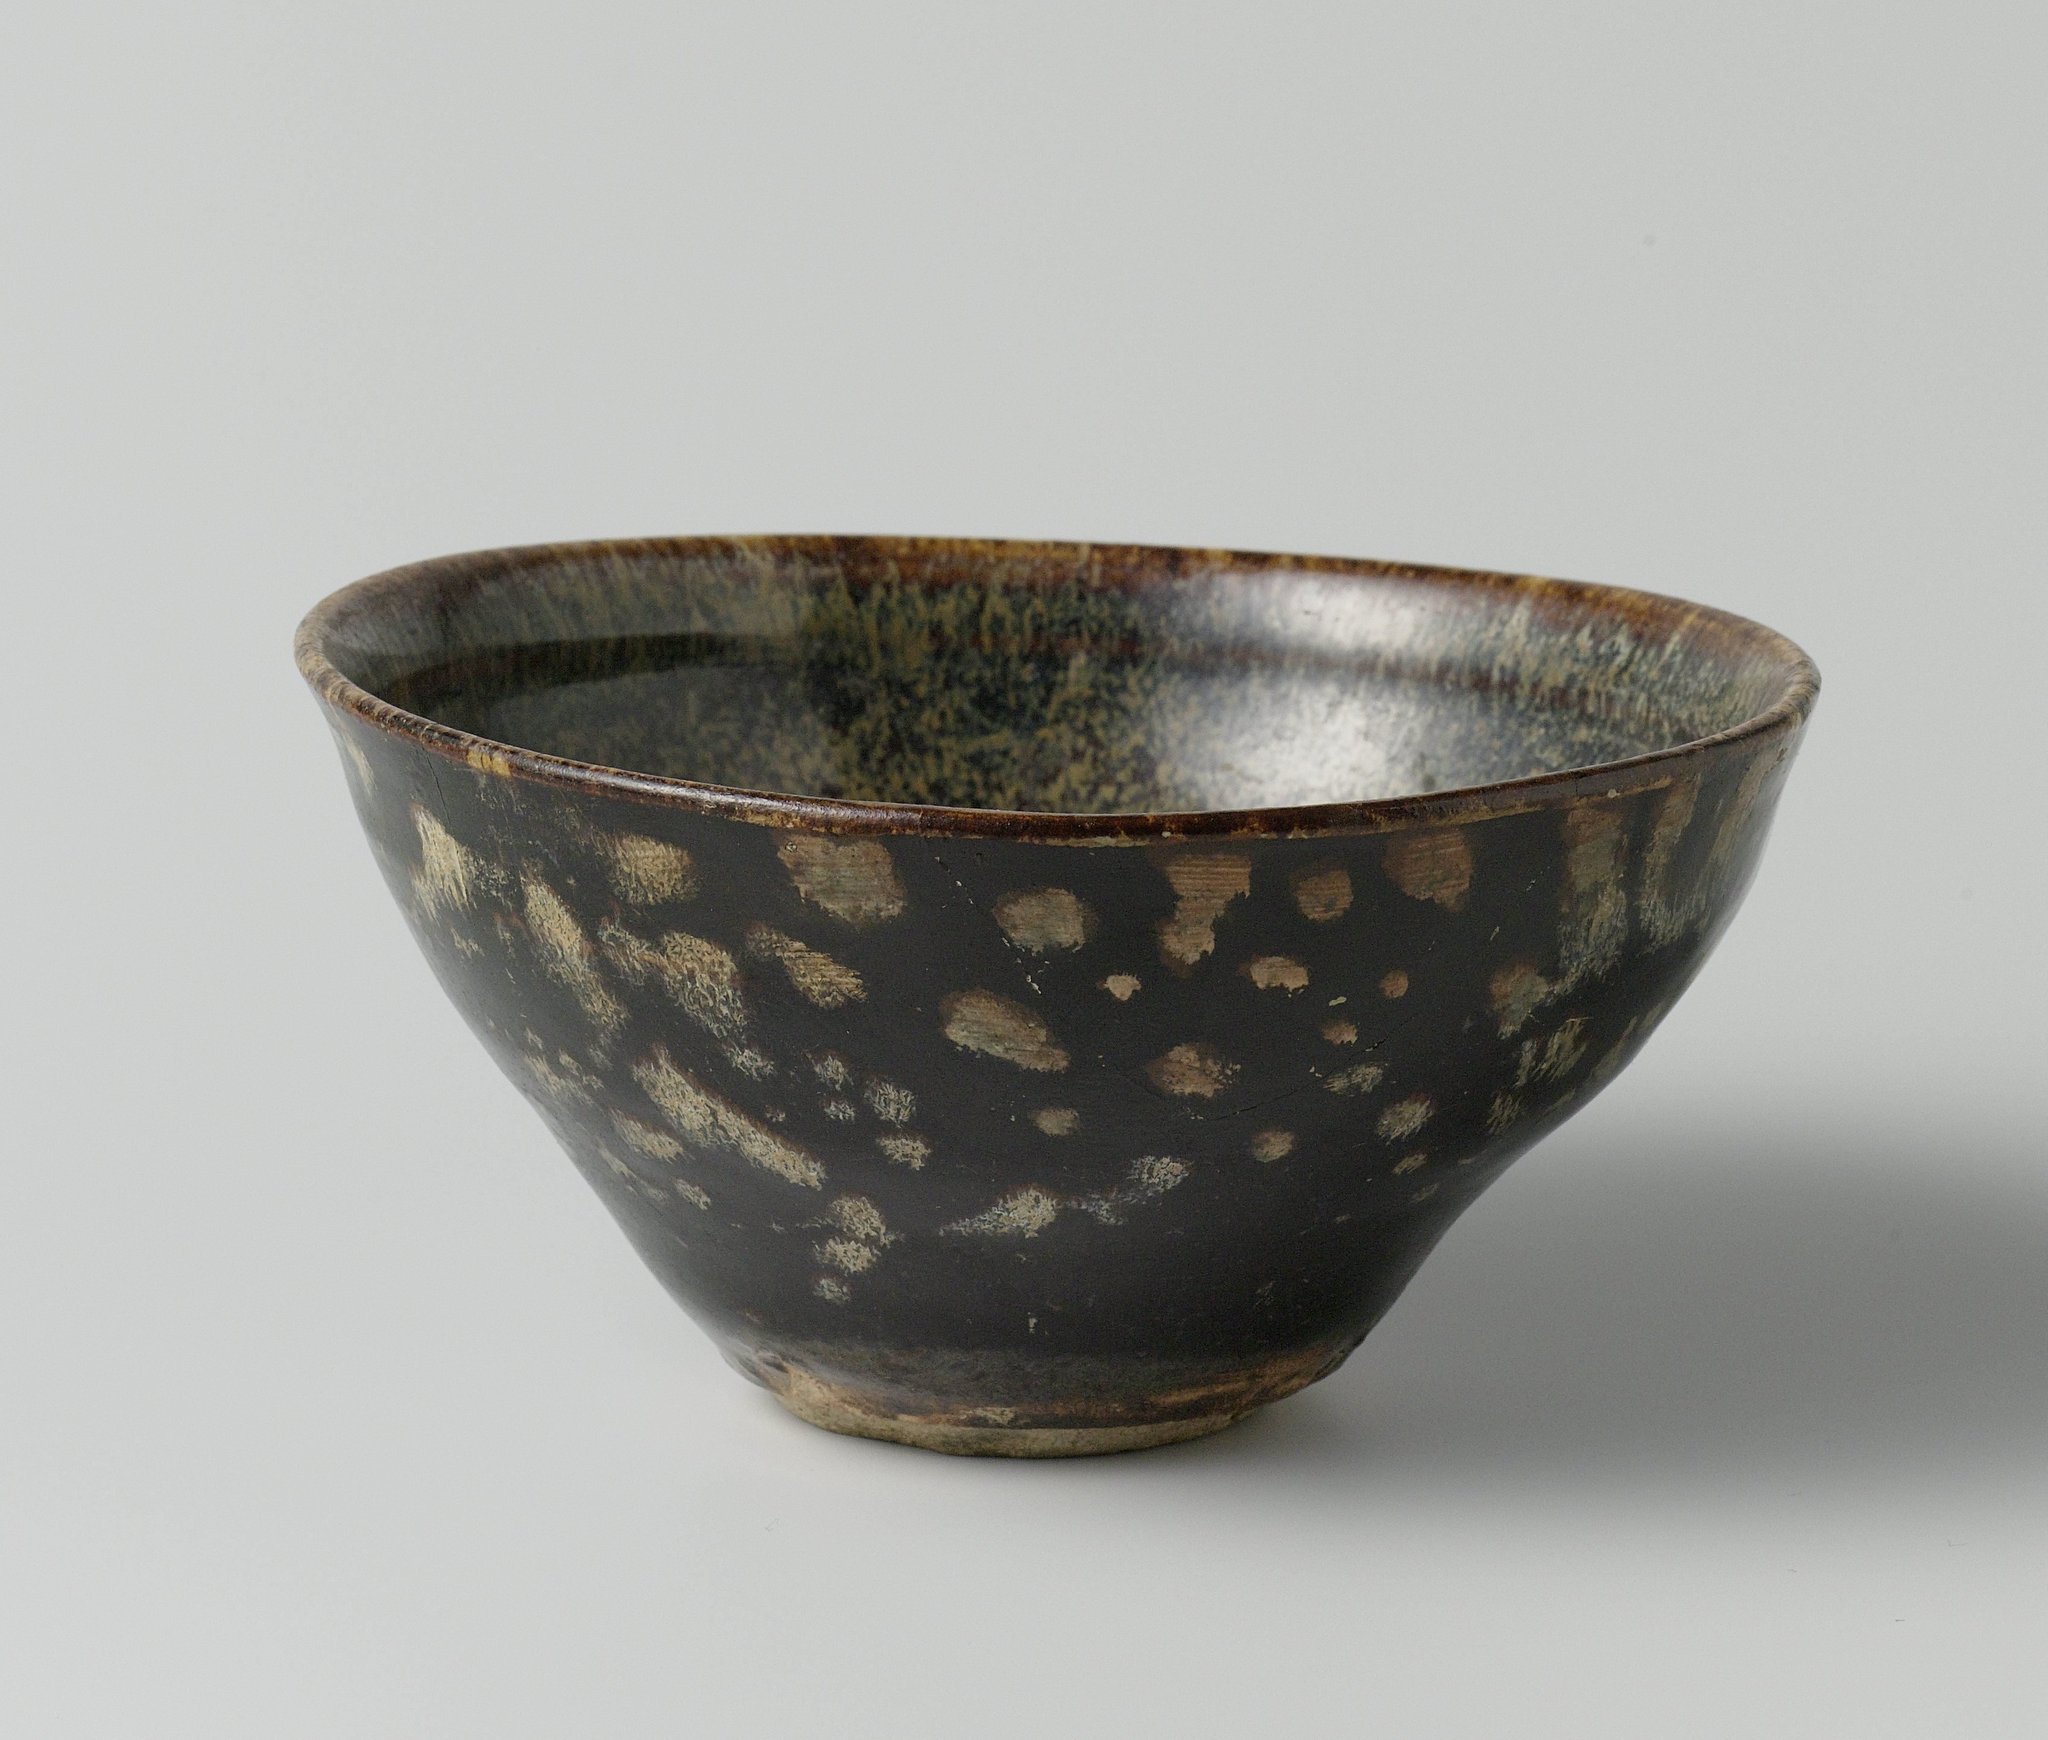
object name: tea bowl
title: Tea bowl with 'tortoiseshell' glaze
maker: Anonymous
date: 1000-1300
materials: glaze, stoneware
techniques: firing, turning, vitrification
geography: china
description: Theekom van steengoed, gedeeltelijk bedekt met een zwartbruin glazuur met aan de buitenzijde crèmekleurige vlekken (tortoiseshell). Op de bodem een uitgespaarde bloem; de binnenwand met tweemaal een uitgespaarde feng huang en tweemaal een vlinder. De wand is gebroken geweest. Jizhou.